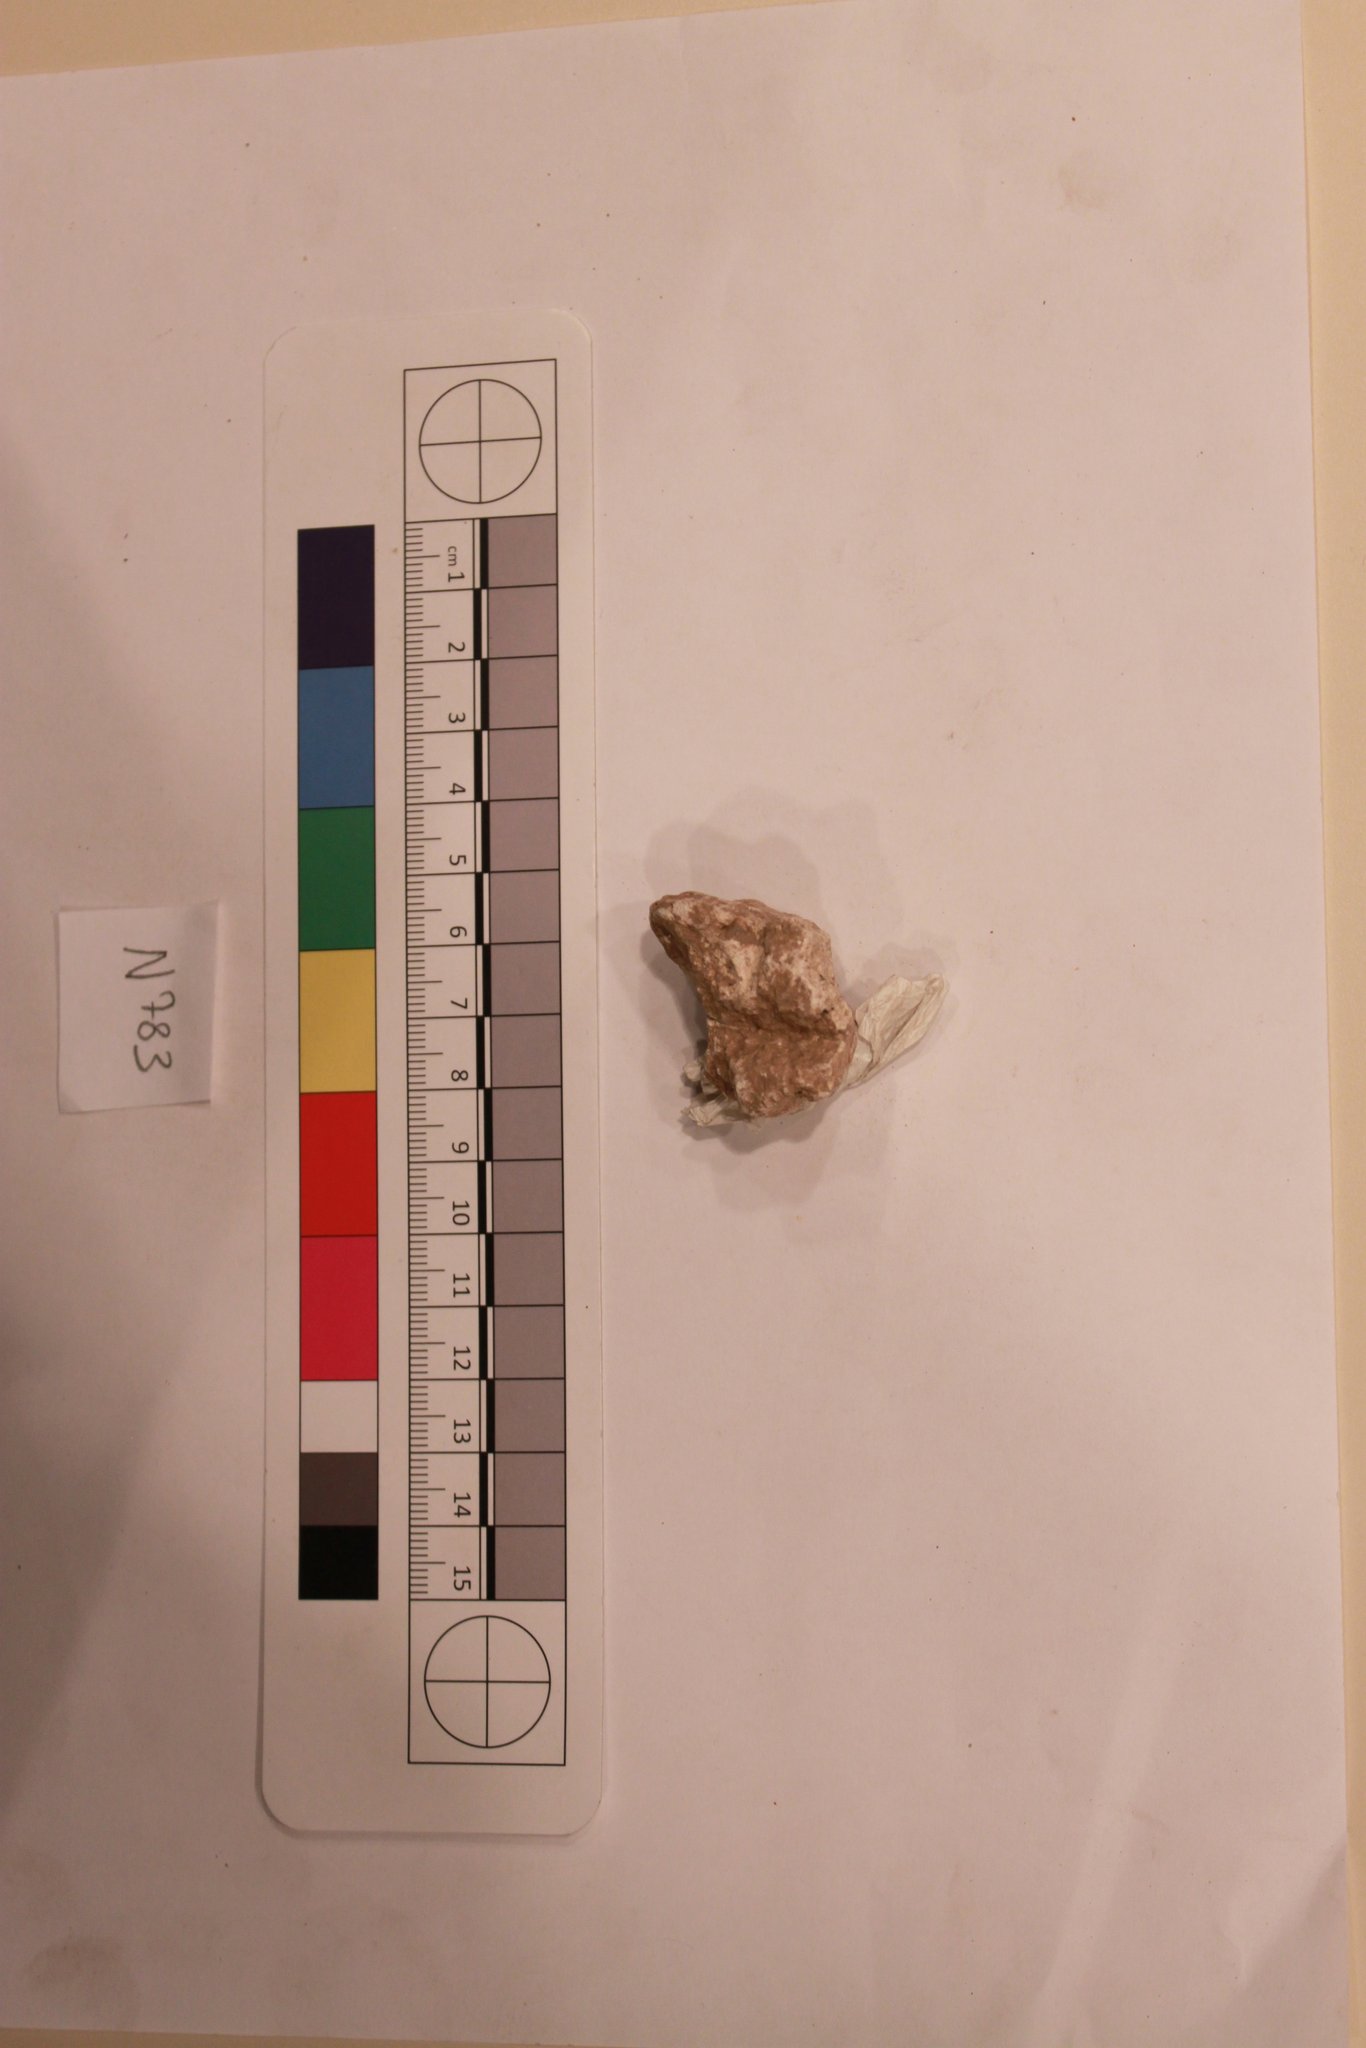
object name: fragment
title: Stucco Fragment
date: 701-1200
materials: plaster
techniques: carving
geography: iran